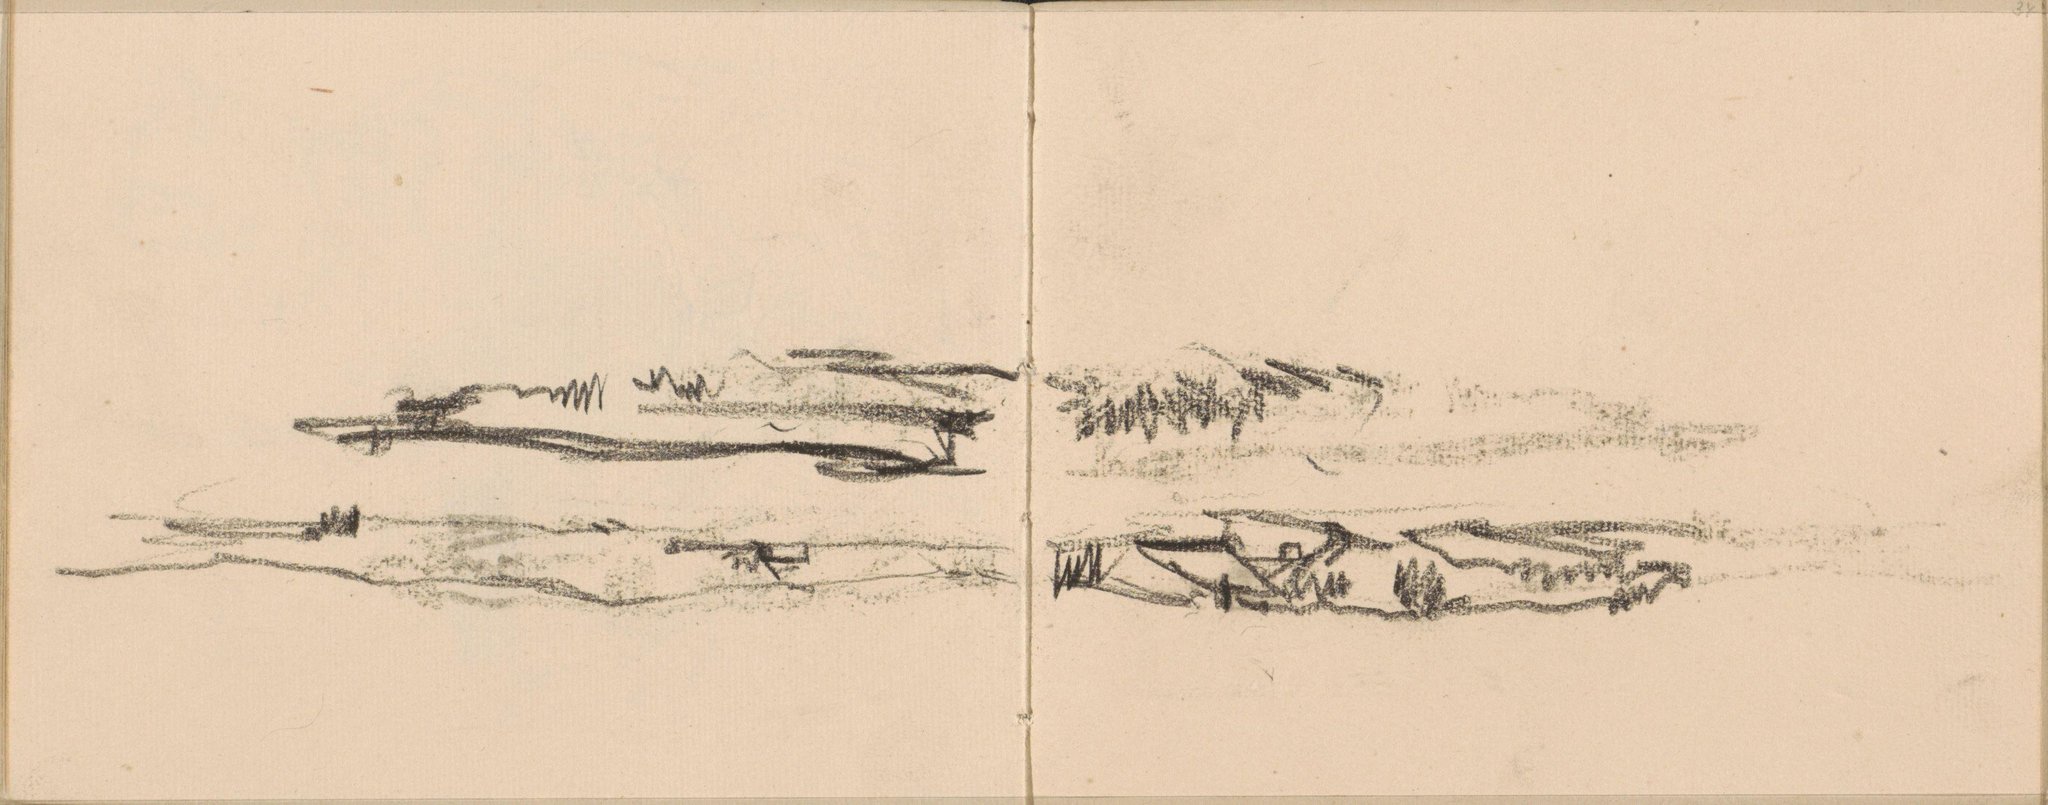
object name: sketchbook leaf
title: Boerderij in een landschap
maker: george hendrik breitner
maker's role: draughtsman, painter, print maker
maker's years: 1857-1923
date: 1885-1898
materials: chalk, paper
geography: ommen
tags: farm or solitary house in landscape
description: Pagina 33 en pagina 34 uit een schetsboek met 32 bladen.